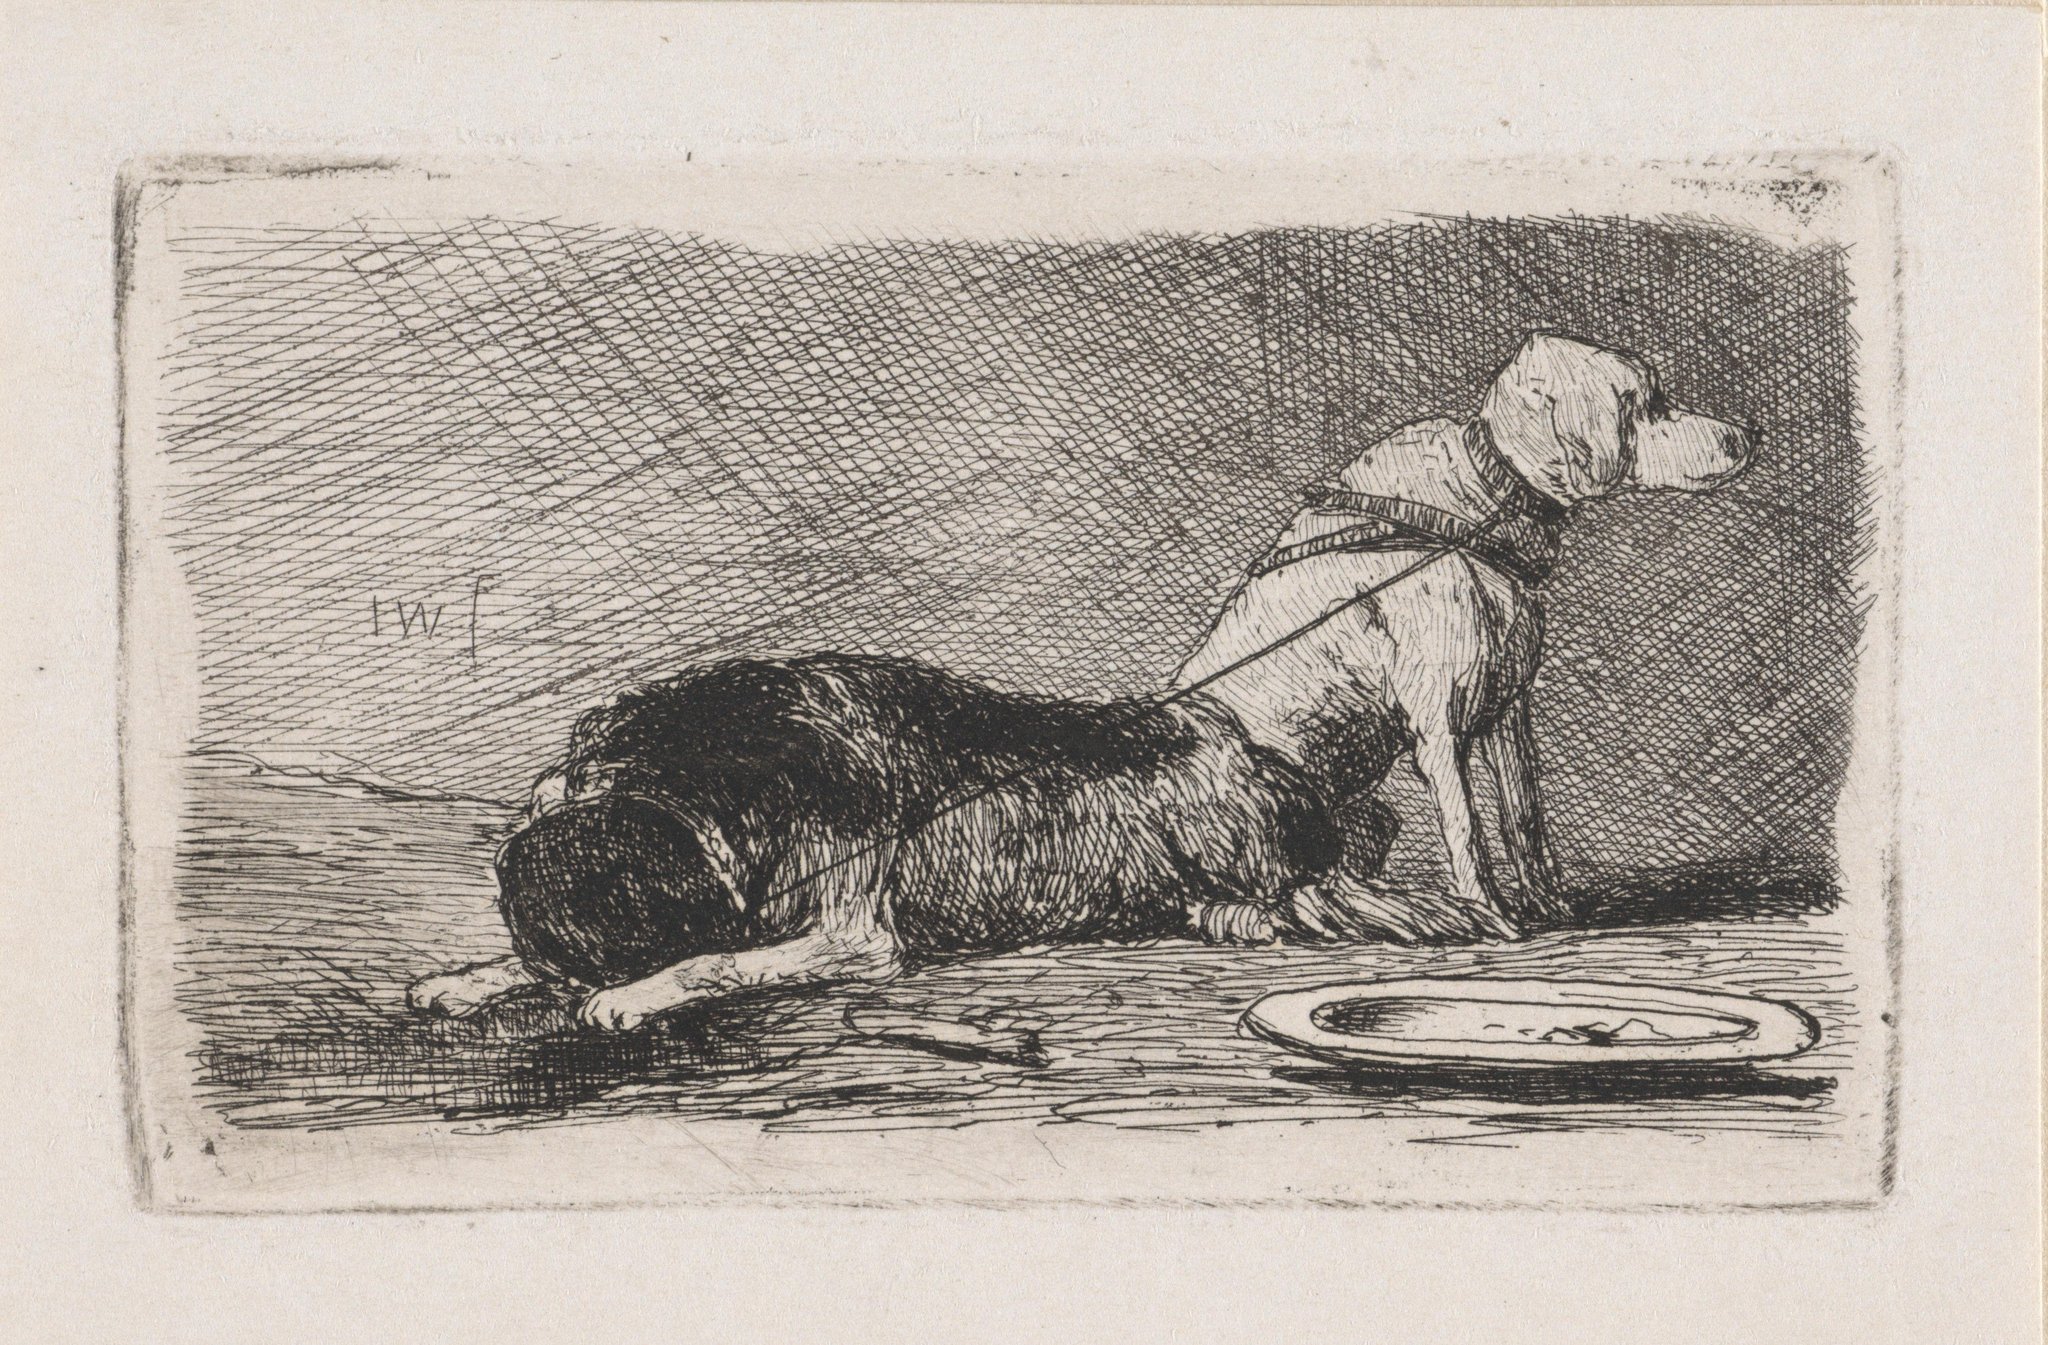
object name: print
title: Twee vastgebonden honden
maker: jan weissenbruch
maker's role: painter, print maker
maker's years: 1822-1880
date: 1837-1880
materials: paper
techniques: etching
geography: the hague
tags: animals tied up, dish, plate, saucer, dog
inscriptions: collector's mark: Lugt 2228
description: Een hond ligt op de grond naast een bot. Hij is vastgebonden aan de tweede hond die achter hem zit. Rechts vooraan staat een leeg bord.